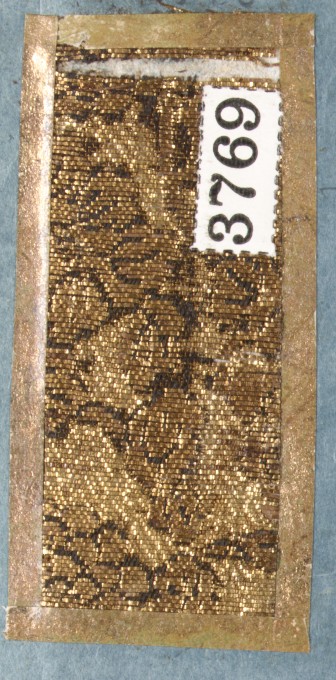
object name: sample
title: Textile Sample from Sample Book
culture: japanese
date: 1801-1900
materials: silk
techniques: tapestry